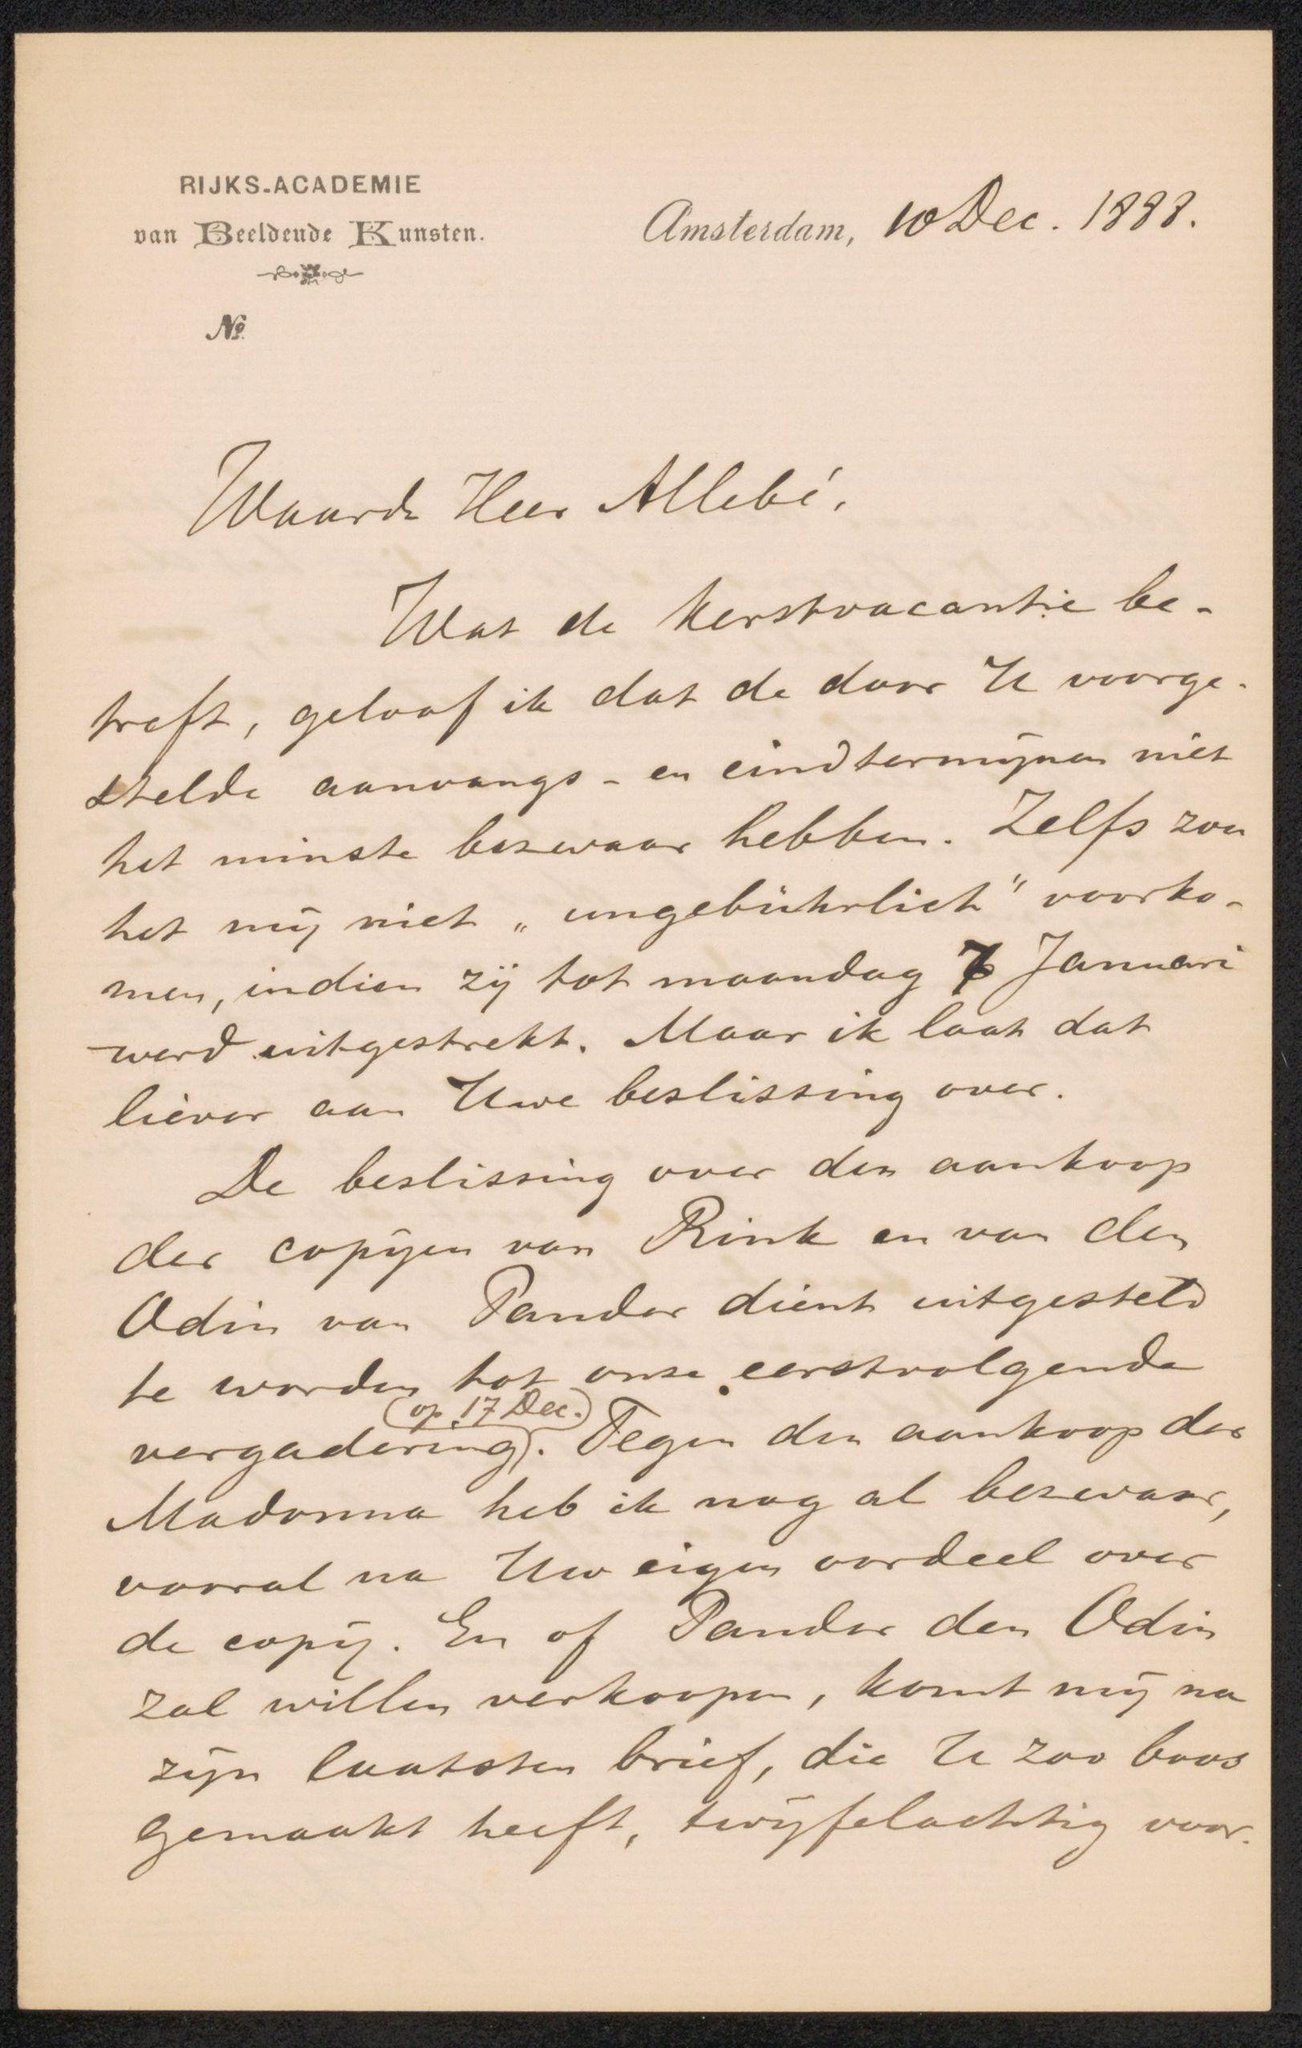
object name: letter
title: Brief aan August Allebé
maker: jérôme alexander sillem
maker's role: politician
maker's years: 1840-1912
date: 1888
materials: ink, paper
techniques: pen, printing, writing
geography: amsterdam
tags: utrecht, anthonius wilhelm cornelis berns, amsterdam, print maker, draughtsman, august allebé, veghel, paul rink, designer, sculptor, pier pander, art trade, art shop, sculpture, education, tuition of the artist (in general), painting (including book-illumination, miniature-painting), art collecting